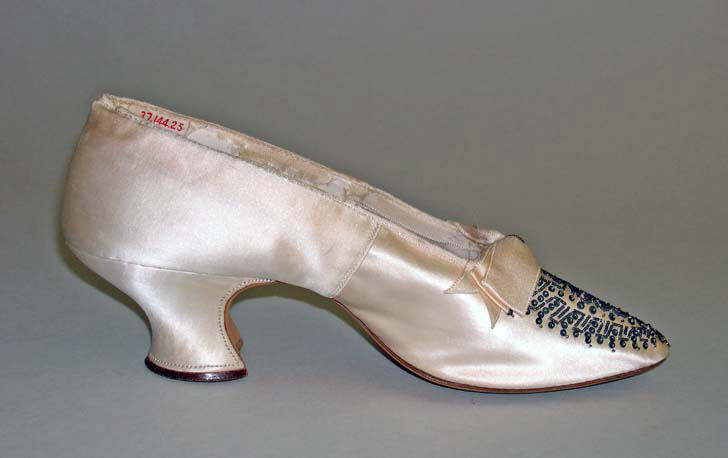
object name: shoe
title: Shoes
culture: french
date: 1890-1899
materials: silk